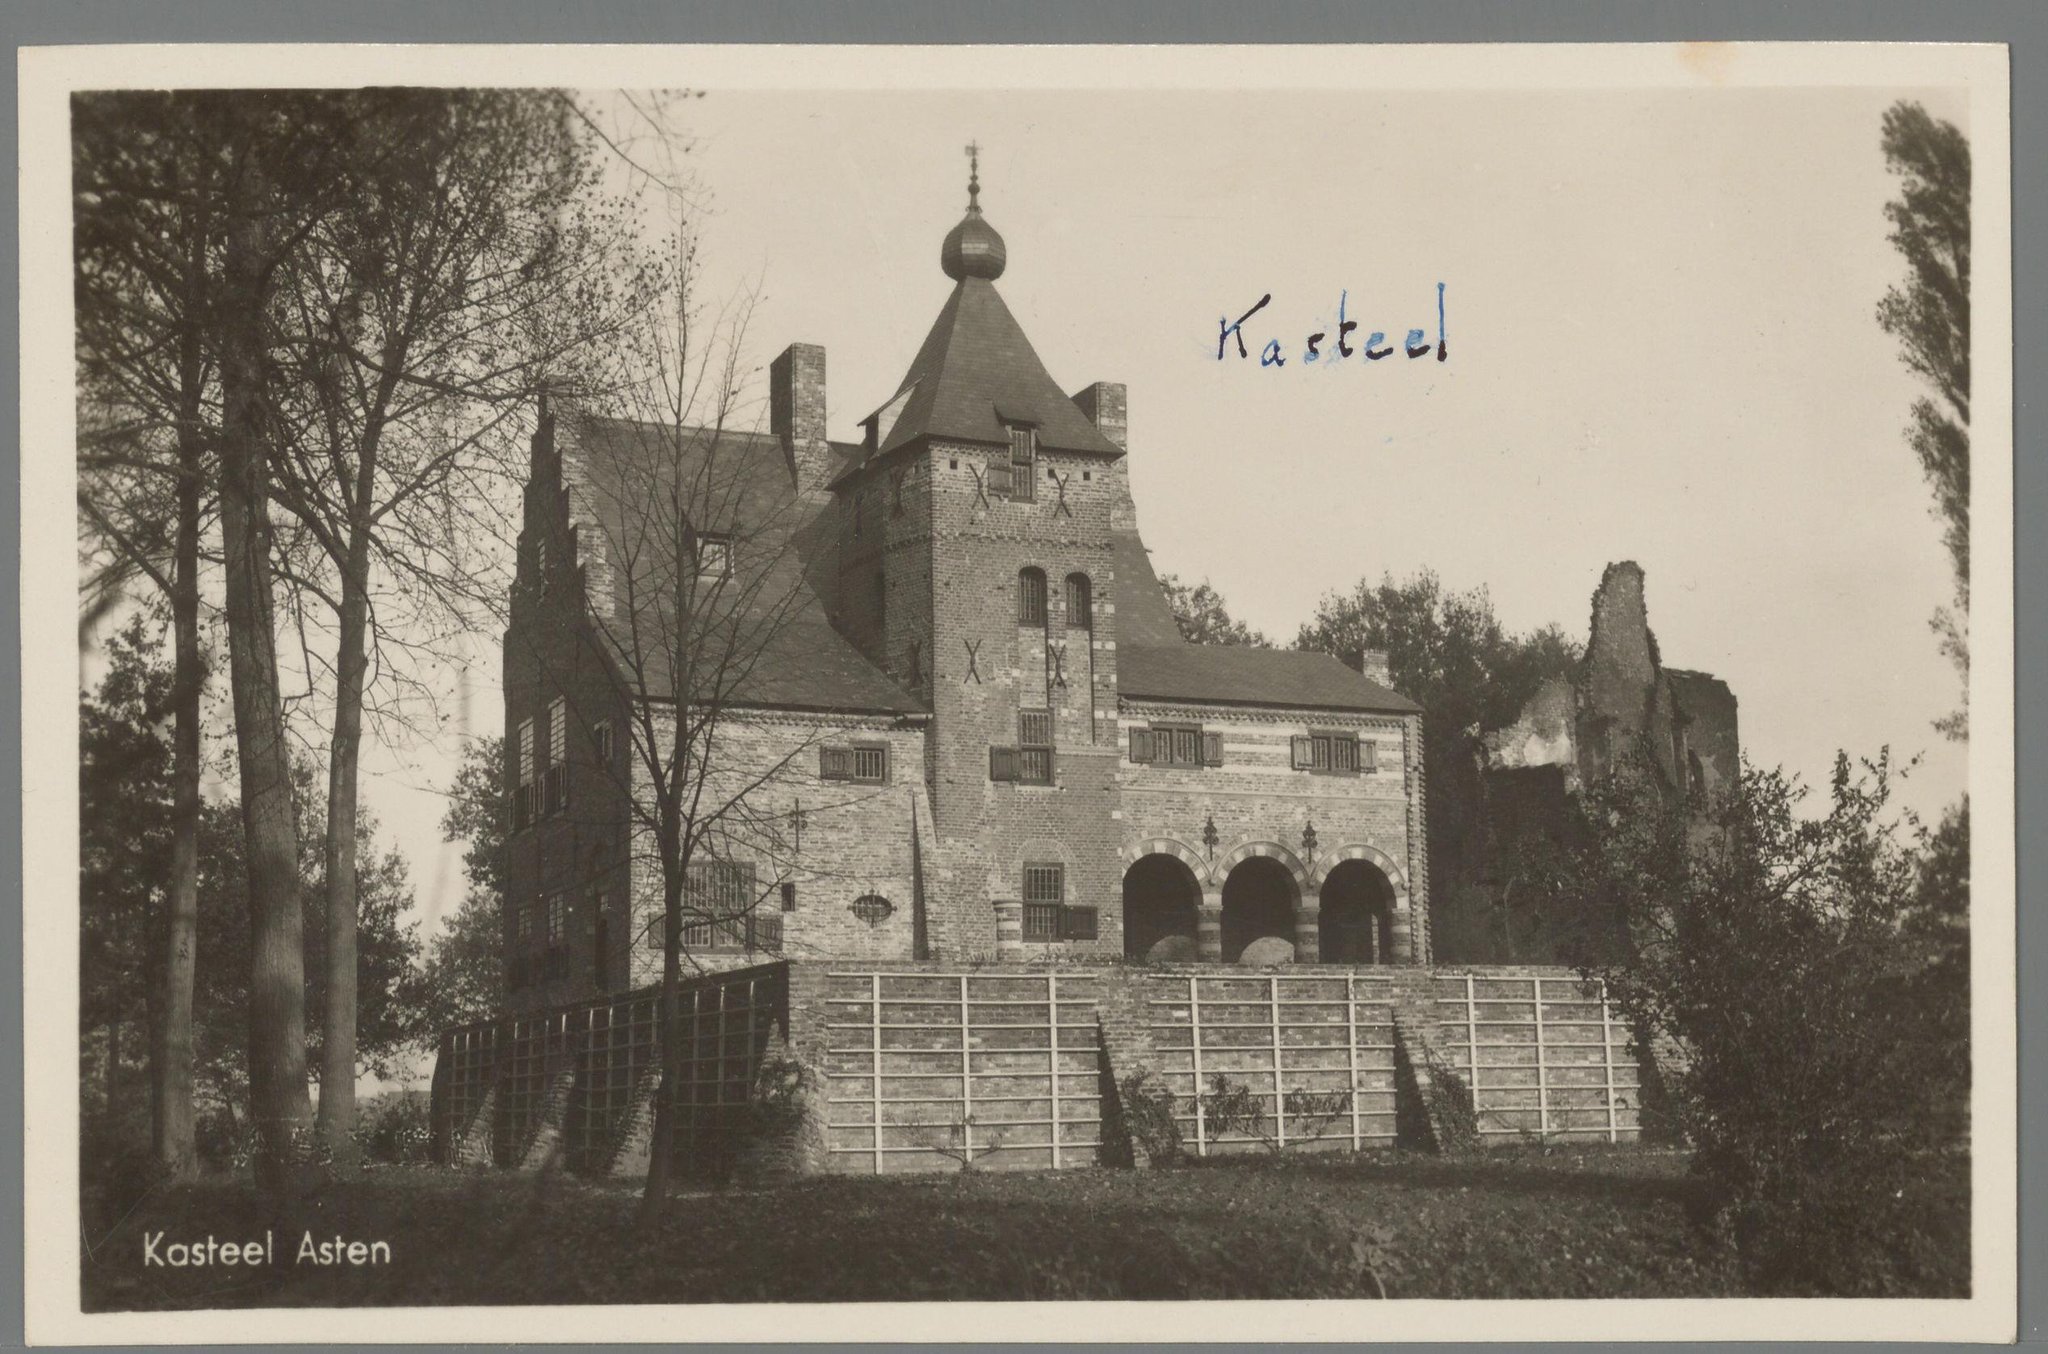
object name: photograph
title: Kasteel Asten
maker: Anonymous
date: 1908-1941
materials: paper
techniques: gelatin silver print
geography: asten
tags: castle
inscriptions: date